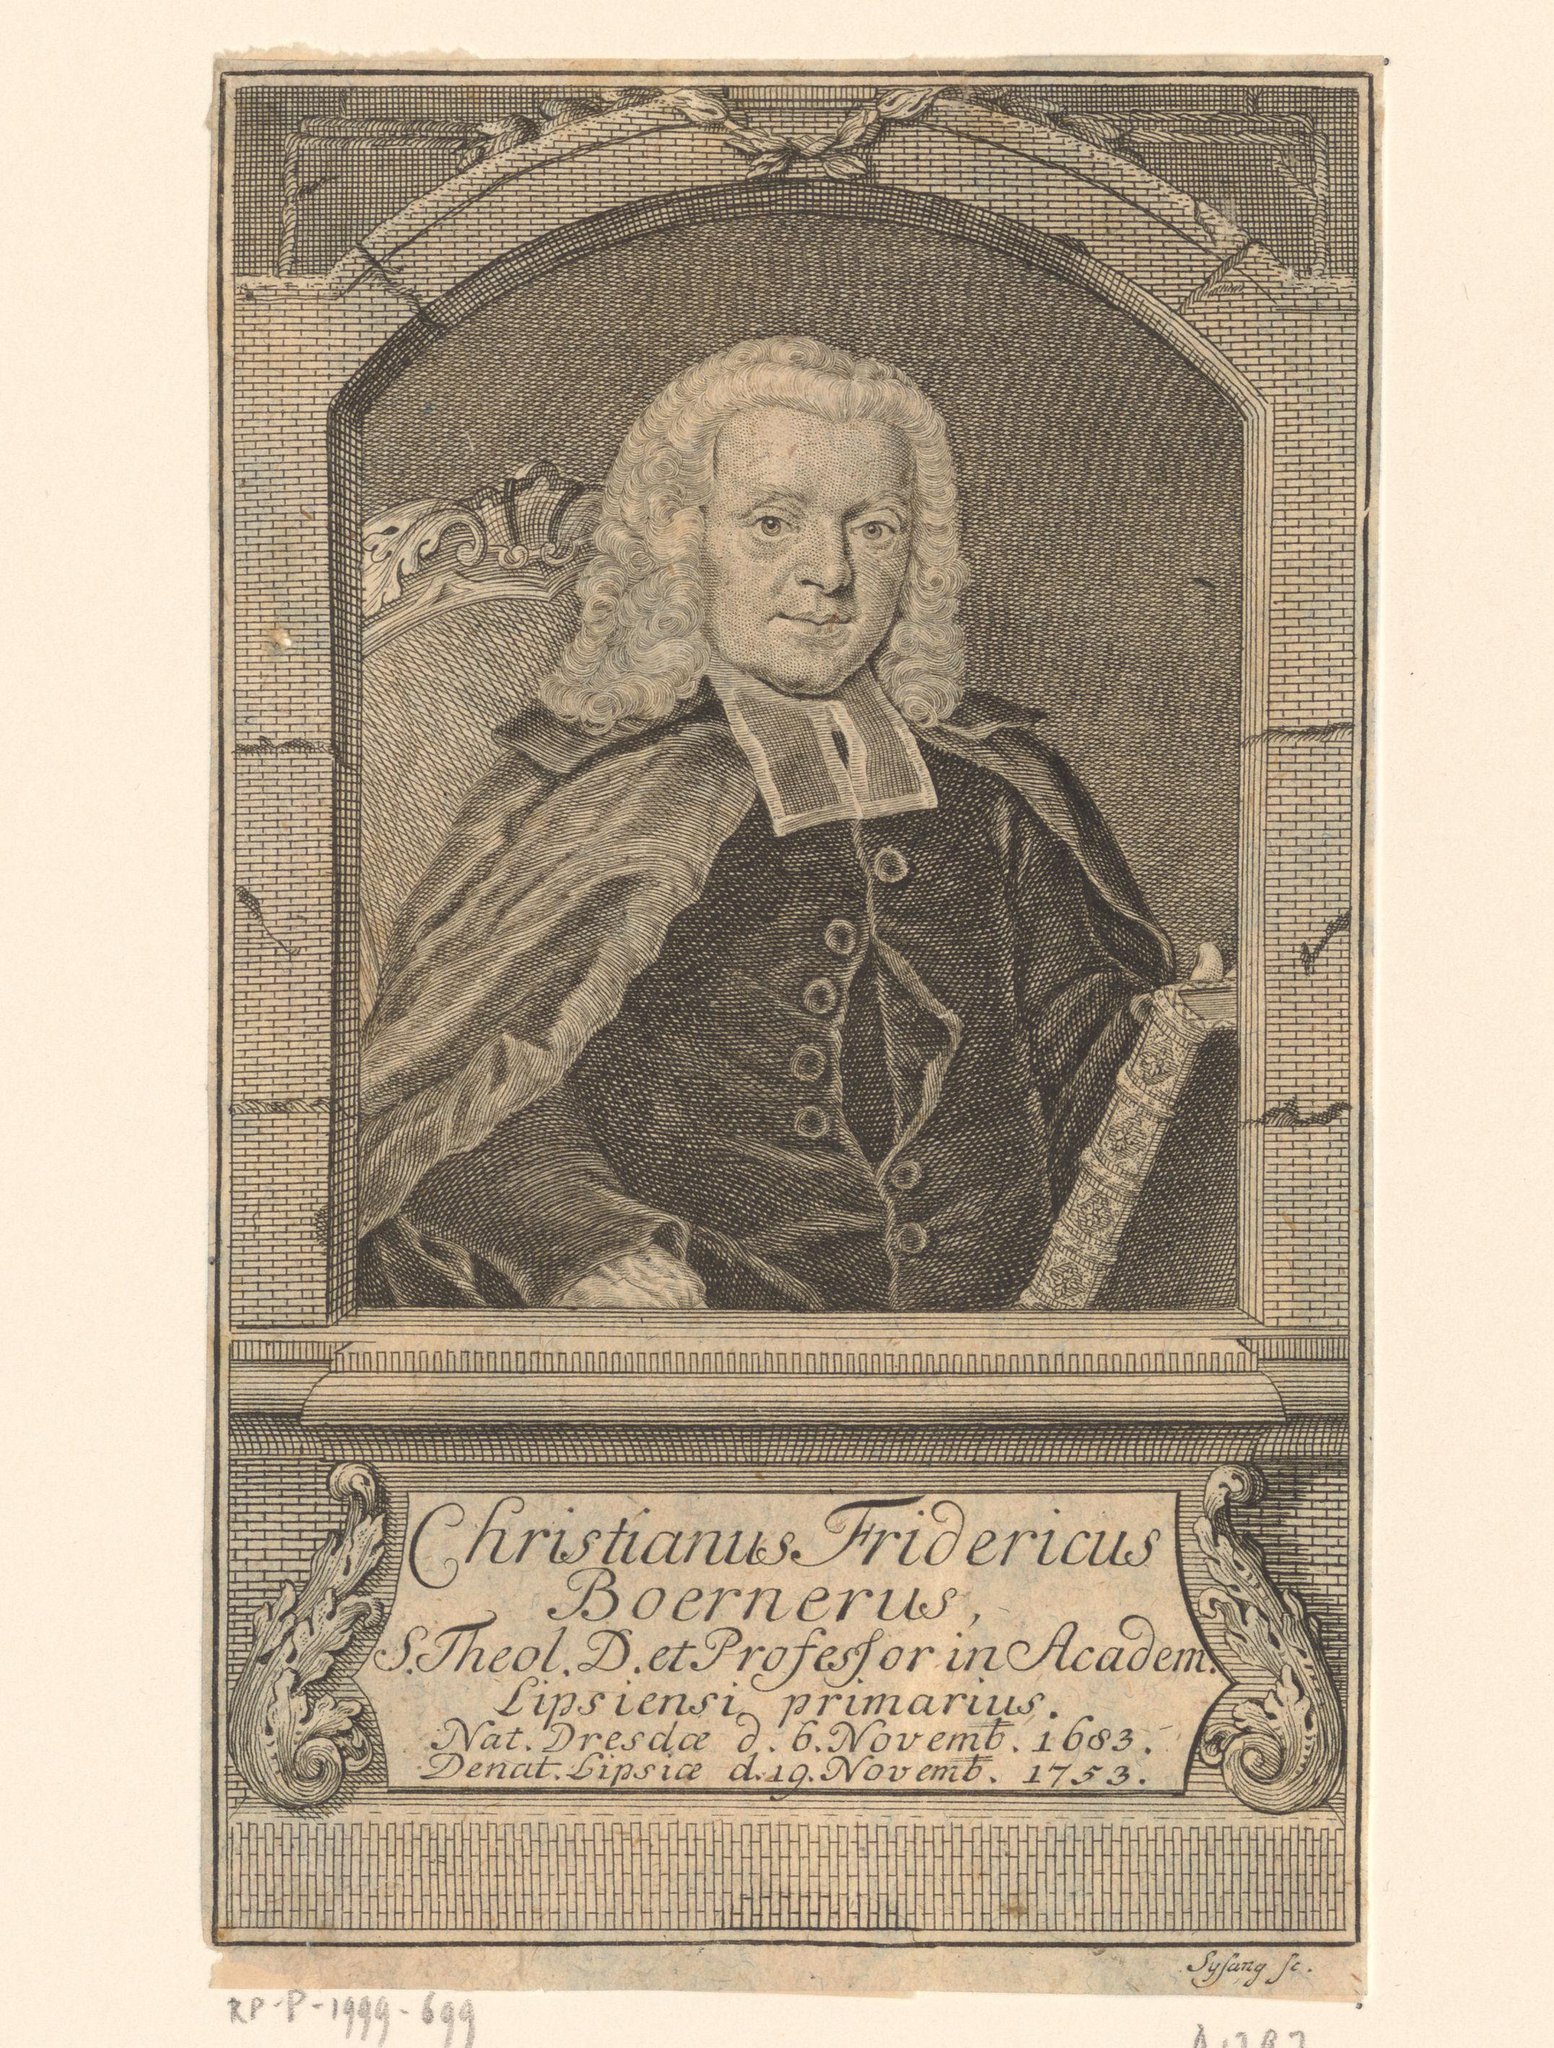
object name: print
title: Portret van Christian Friedrich Boerner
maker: johann christoph sysang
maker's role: print maker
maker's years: 1703-1757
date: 1753-1757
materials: paper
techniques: engraving, etching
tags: historical persons, book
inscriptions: collector's mark: Lugt 2228, collector's mark: Lugt 2760